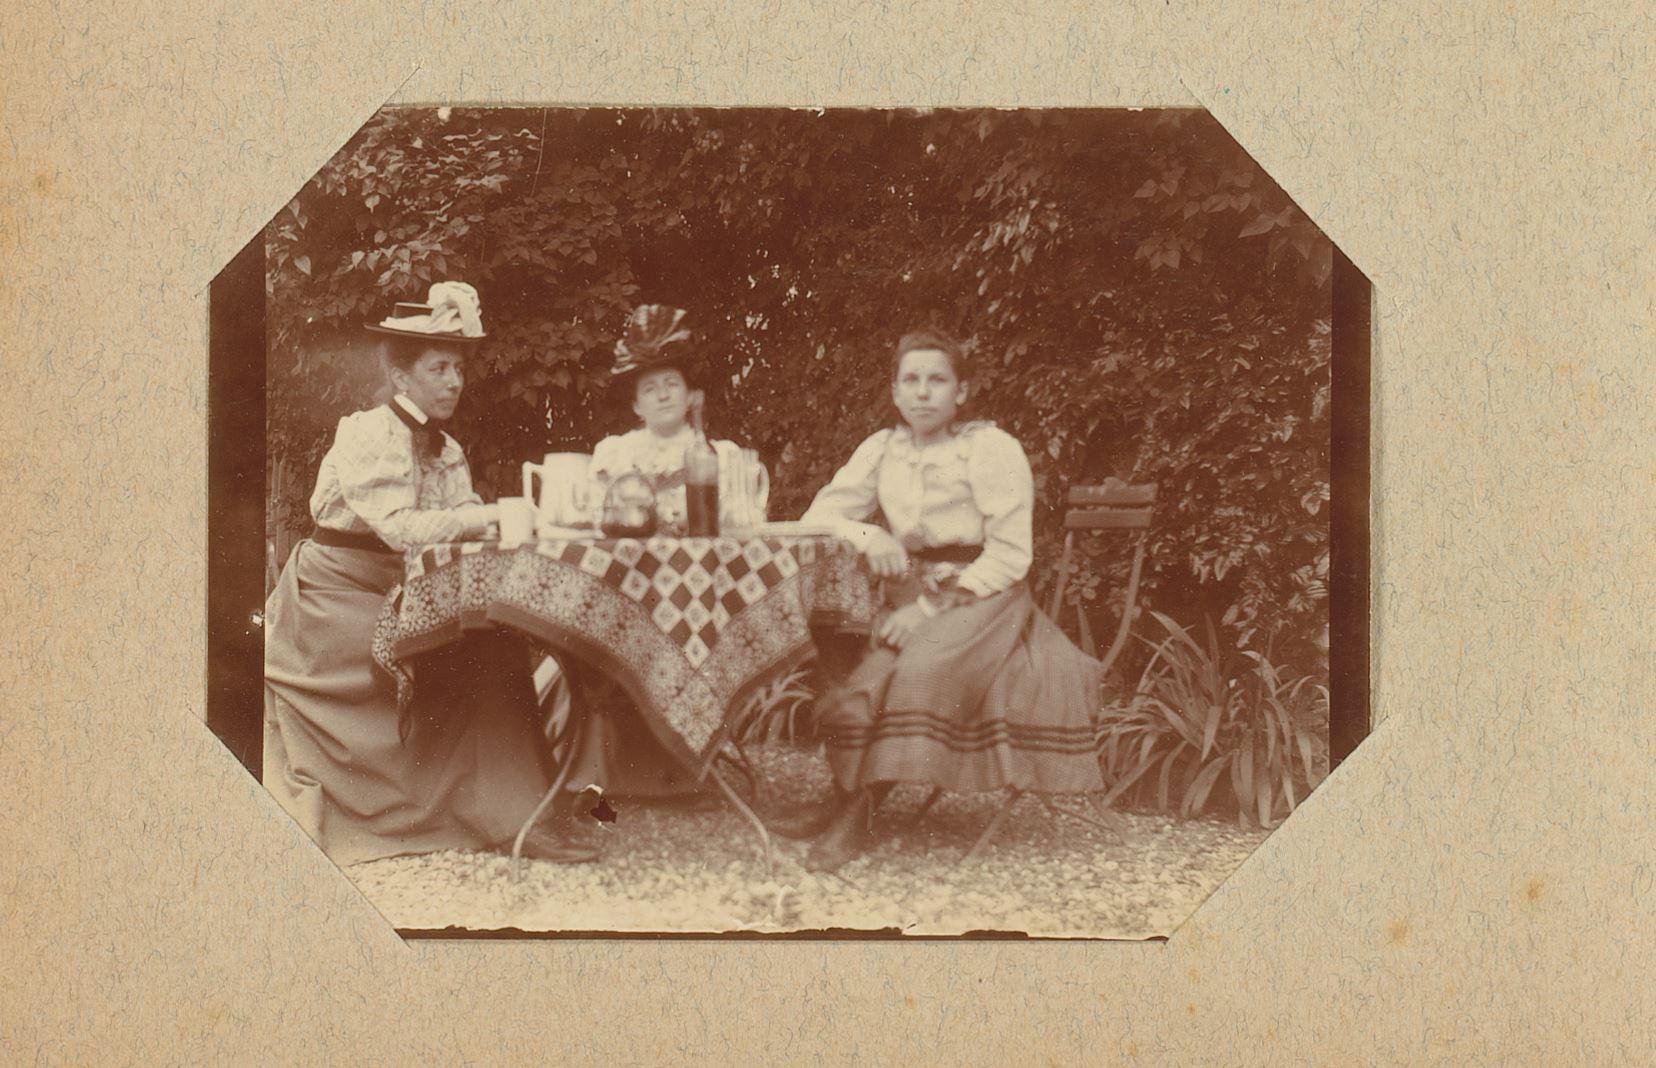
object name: album leaf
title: Drie vrouwen aan een tafel in een tuin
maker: Anonymous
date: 1897-1900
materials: paper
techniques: gelatin silver print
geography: france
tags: adult woman, garden, afternoon tea, france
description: Over de foto is een ander negatief afgedrukt van een voorstelling van bomen.